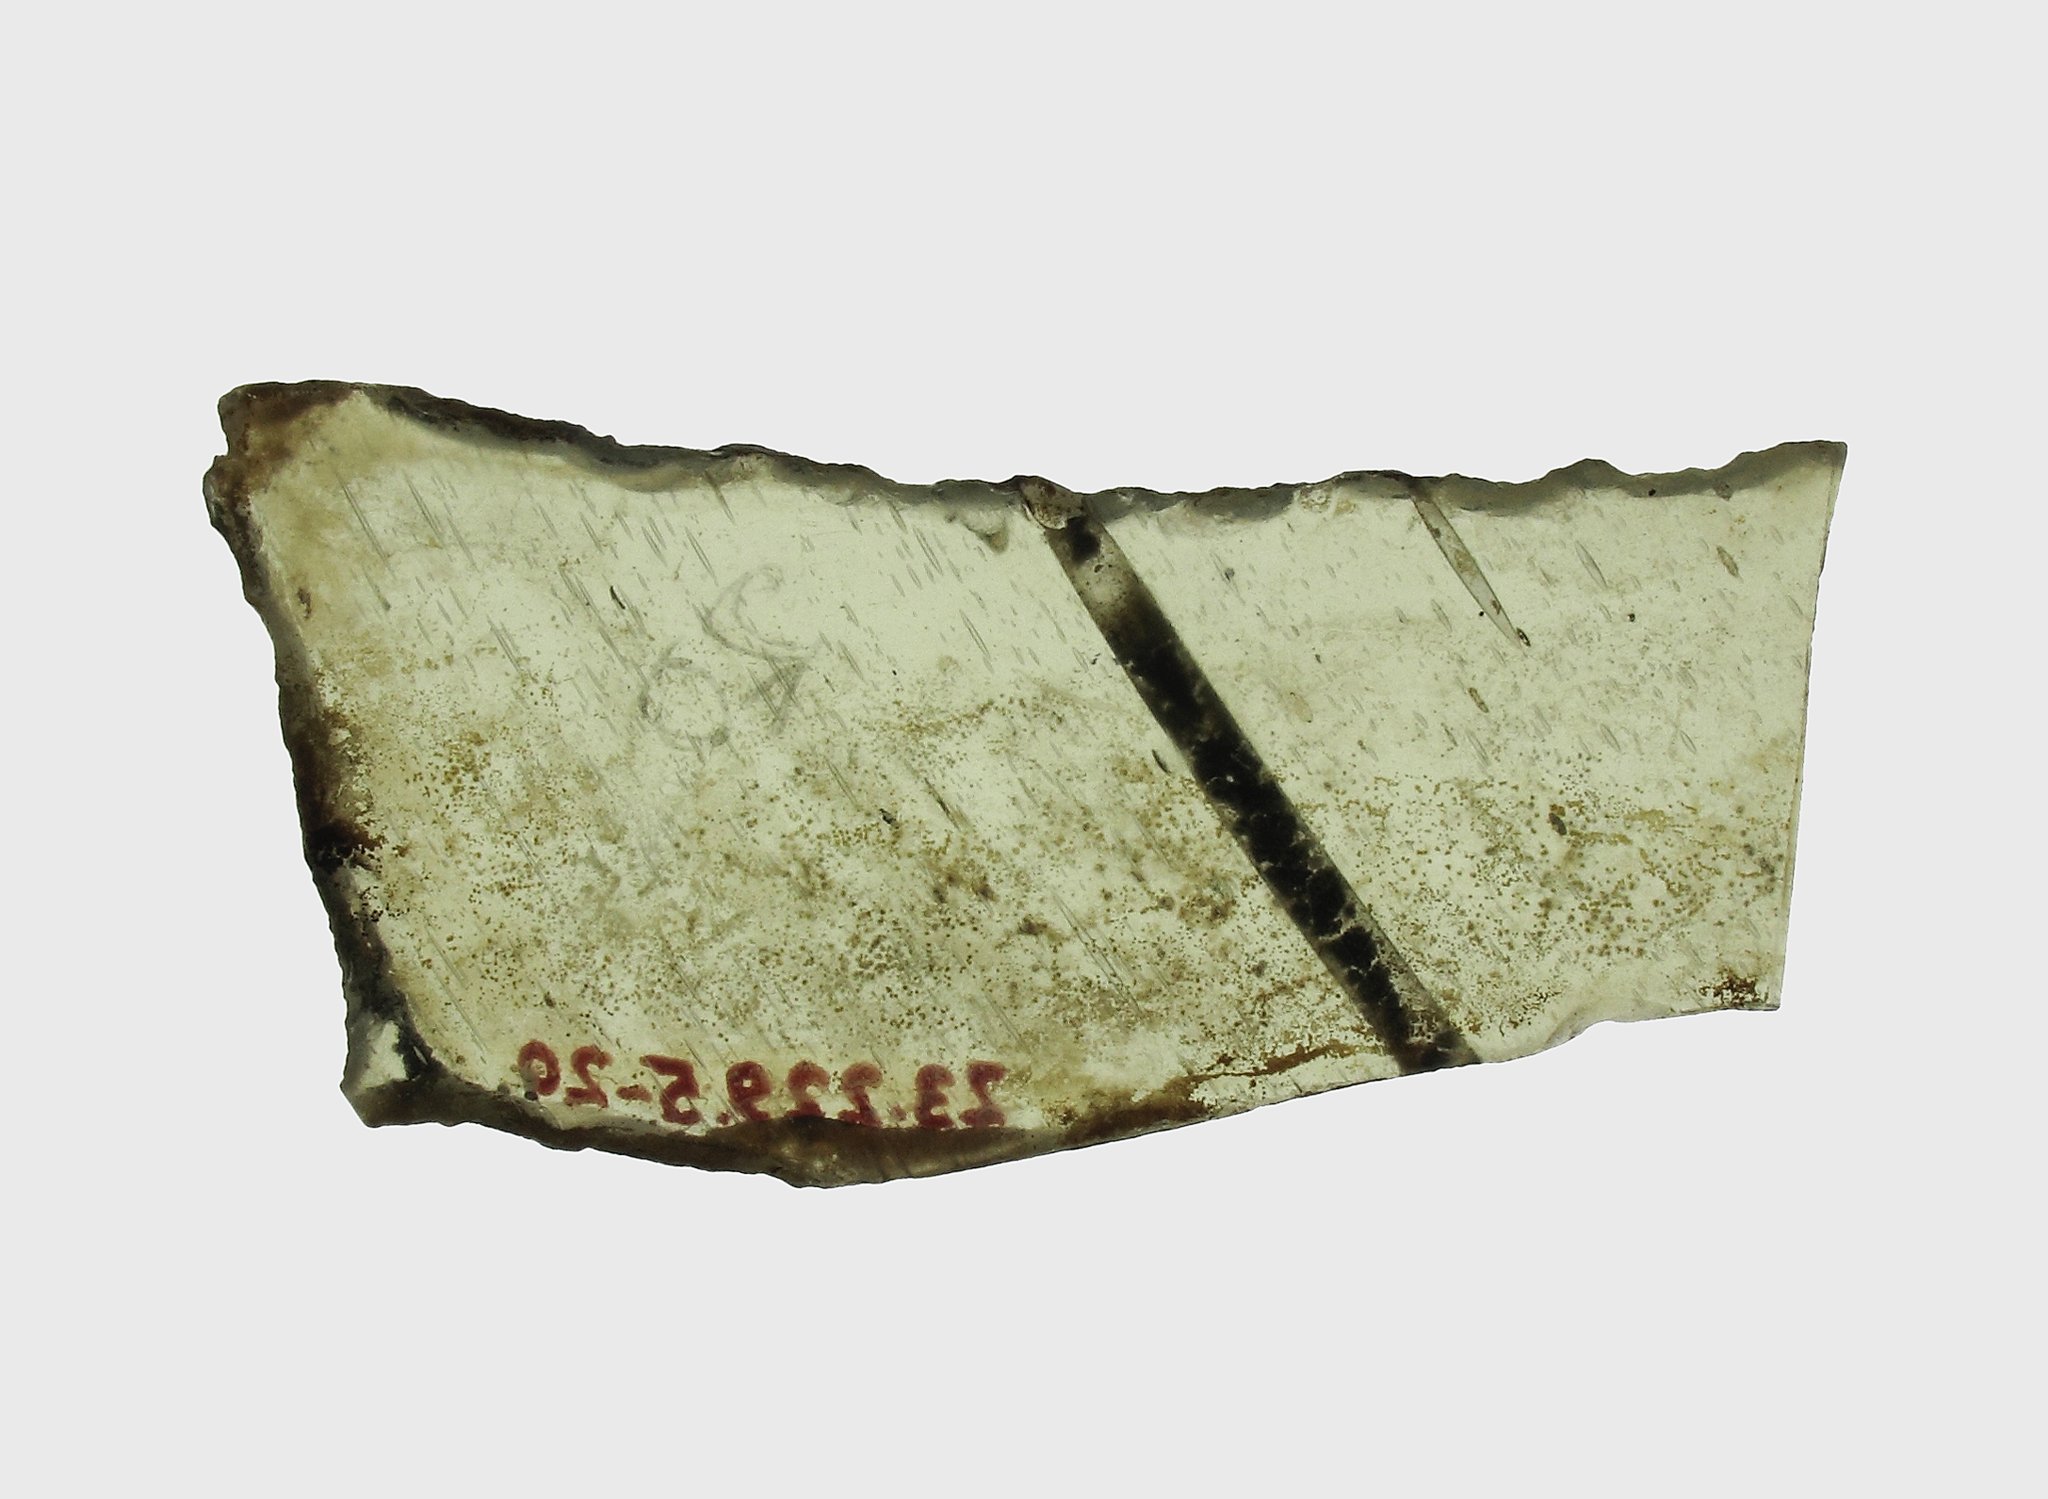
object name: fragment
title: Glass Fragment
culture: french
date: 1301-1500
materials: glass